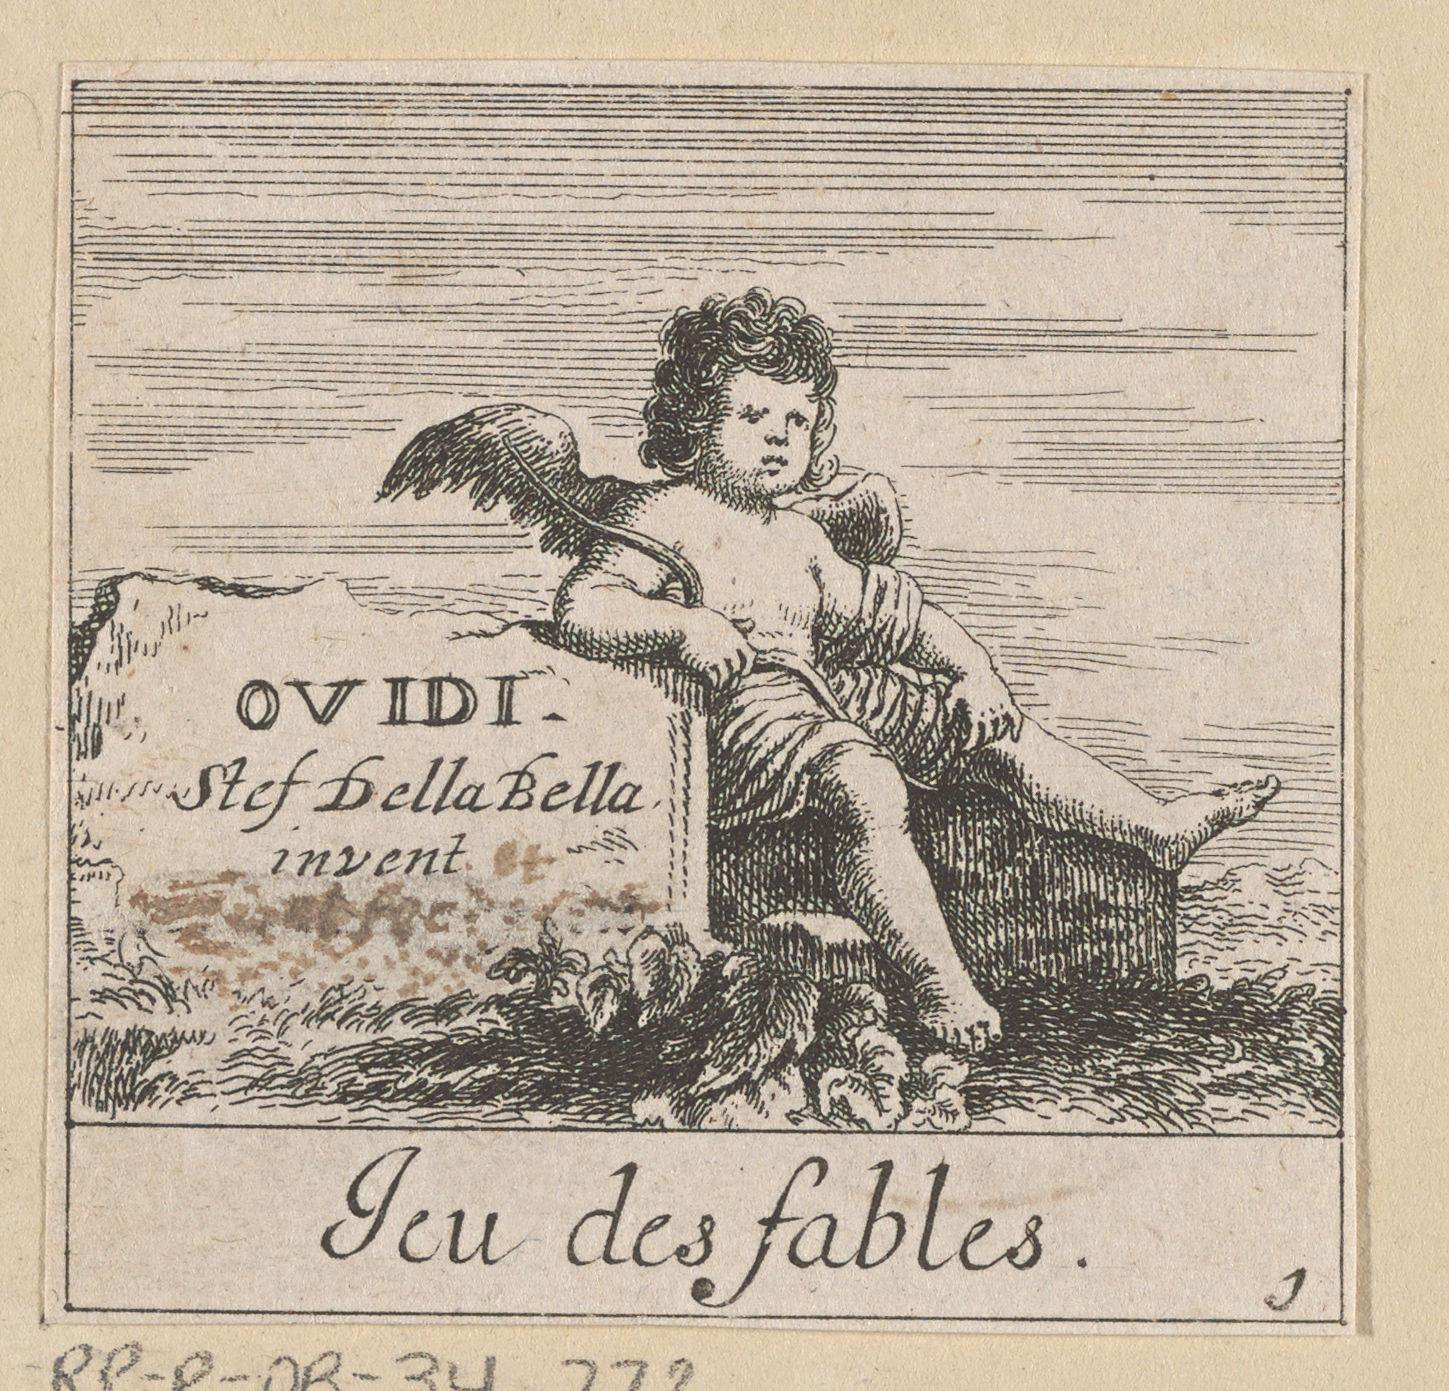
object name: titelprent, frontispice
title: Jeu des fables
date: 1620-1664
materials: paper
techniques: etching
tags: cupids: 'amores', 'amoretti', 'putti'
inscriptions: collector's mark: Lugt 240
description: Prent uit een reeks van 54 genummerde speelkaarten met voorstellingen uit de Metamorfosen van Ovidius.